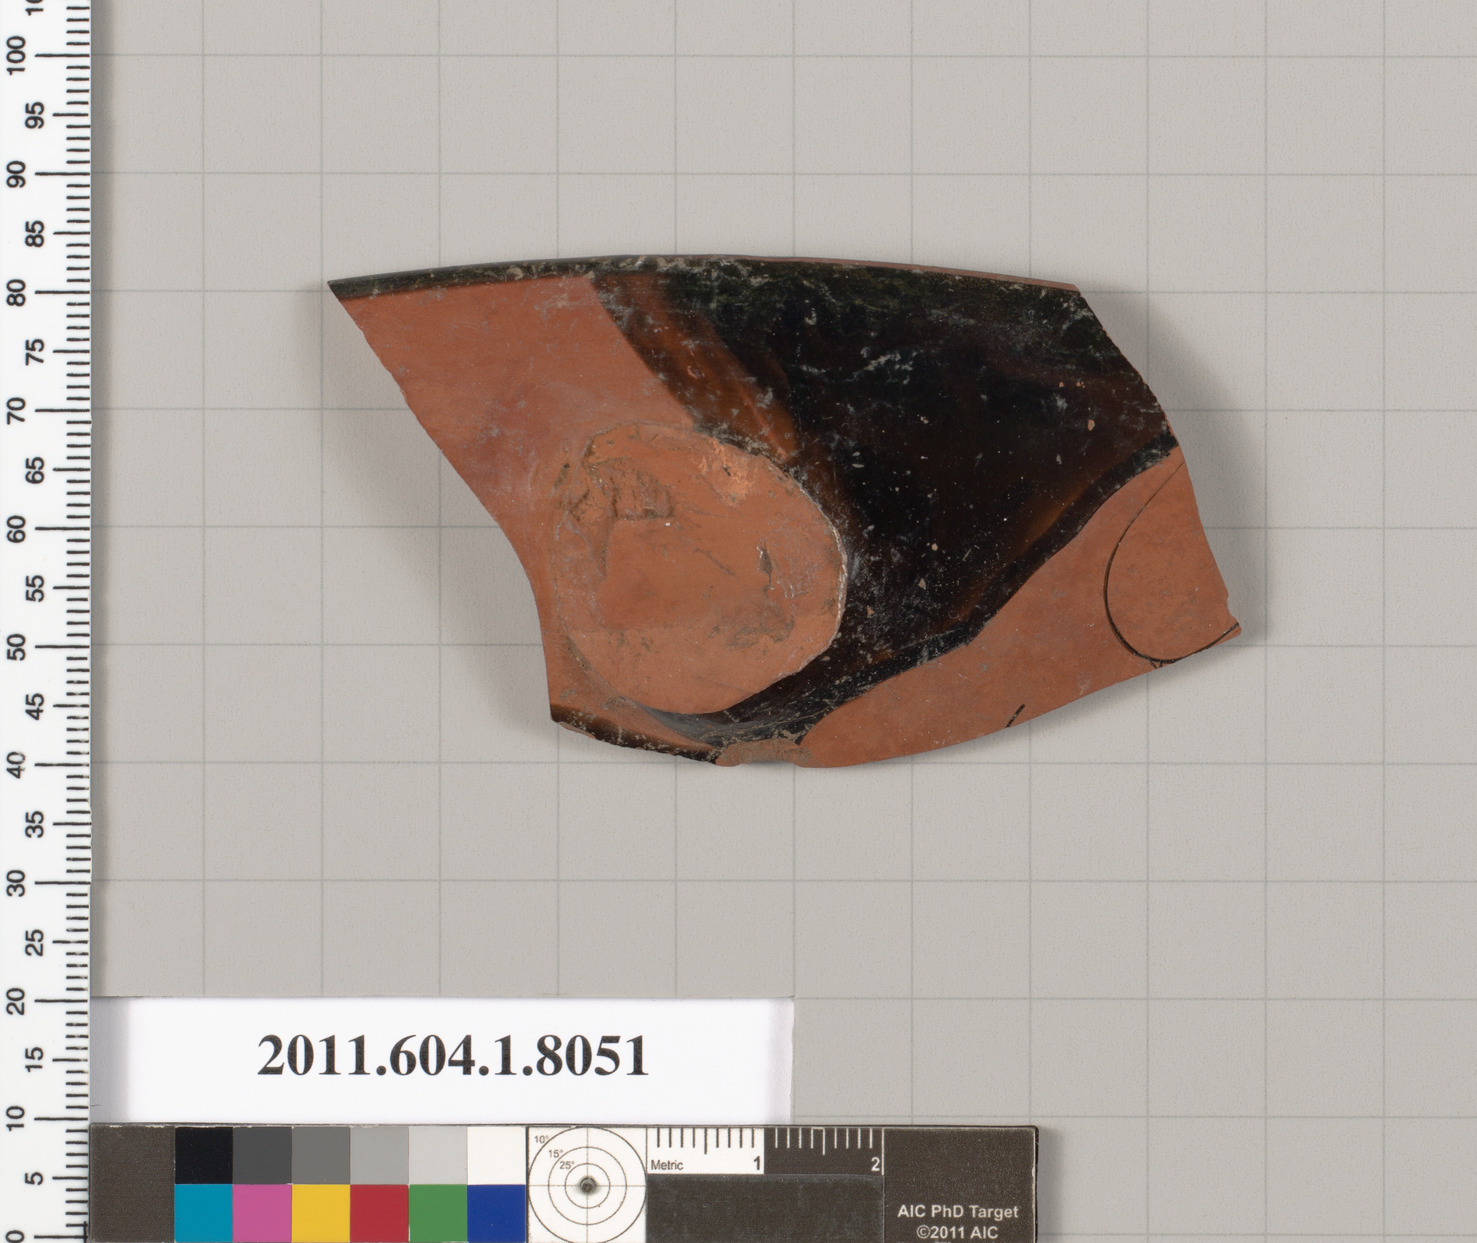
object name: kylix fragment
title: Terracotta rim fragment of a kylix (drinking cup)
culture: greek, attic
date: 510-500 BCE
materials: terracotta